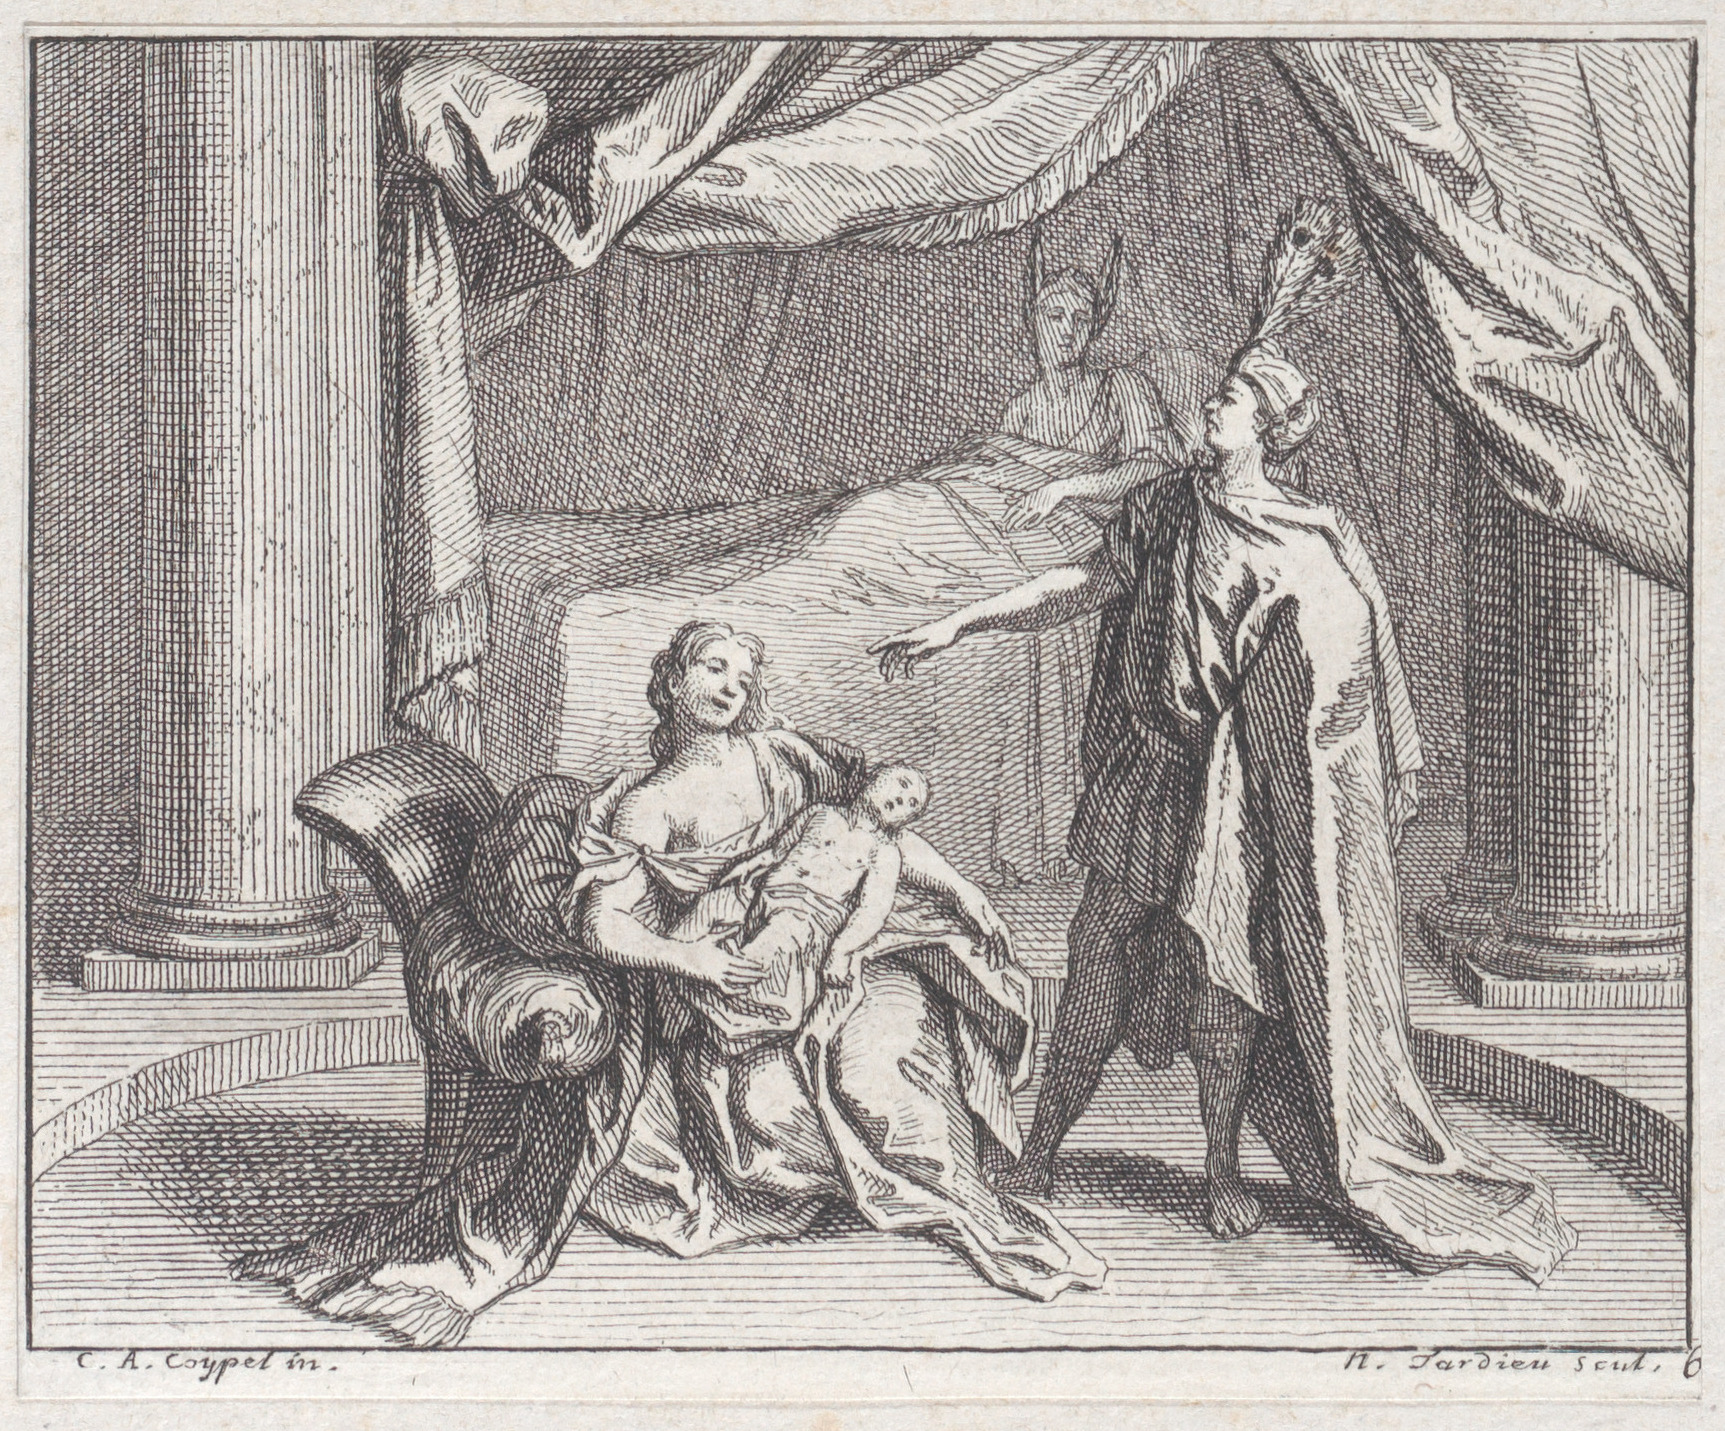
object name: print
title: Book 4, Fable 3: the Opinion (L'Opinion), from "Fables Nouvelles"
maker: nicolas henry tardieu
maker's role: artist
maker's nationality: french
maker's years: 1674-1749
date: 1719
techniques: engraving, etching